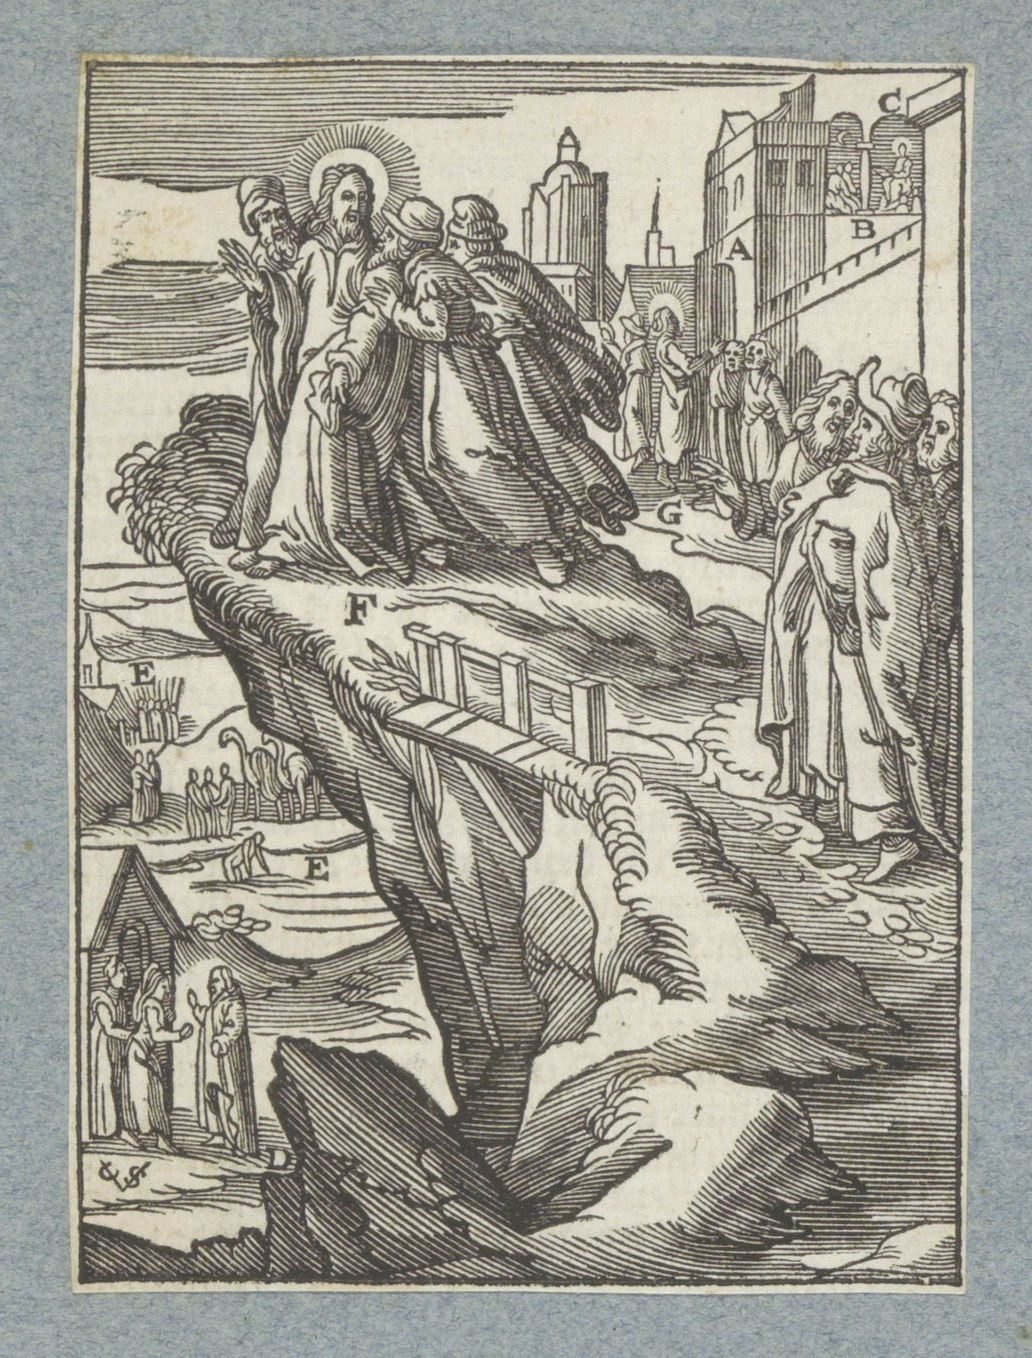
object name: book illustration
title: Inwoners van Nazaret verdrijven Christus uit de stad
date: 1629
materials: paper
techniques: letterpress printing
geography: amsterdam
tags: christ, having been chased out of nazareth, passes unharmed through the multitude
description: Toen de aanwezigen in de synagoge van Nazaret hoorden dat niemand van hen van huidvraat werd gereinigd, maar wel de Syriër Naäman, ontstaken ze in grote woede. Hierop drijven ze Christus de stad uit, naar de rand van de berg waarop hun stad gebouwd was, om hem in de afgrond te storten. Bij verschillende elementen uit de voorstelling staan letters. De prent maakt deel uit van een album.